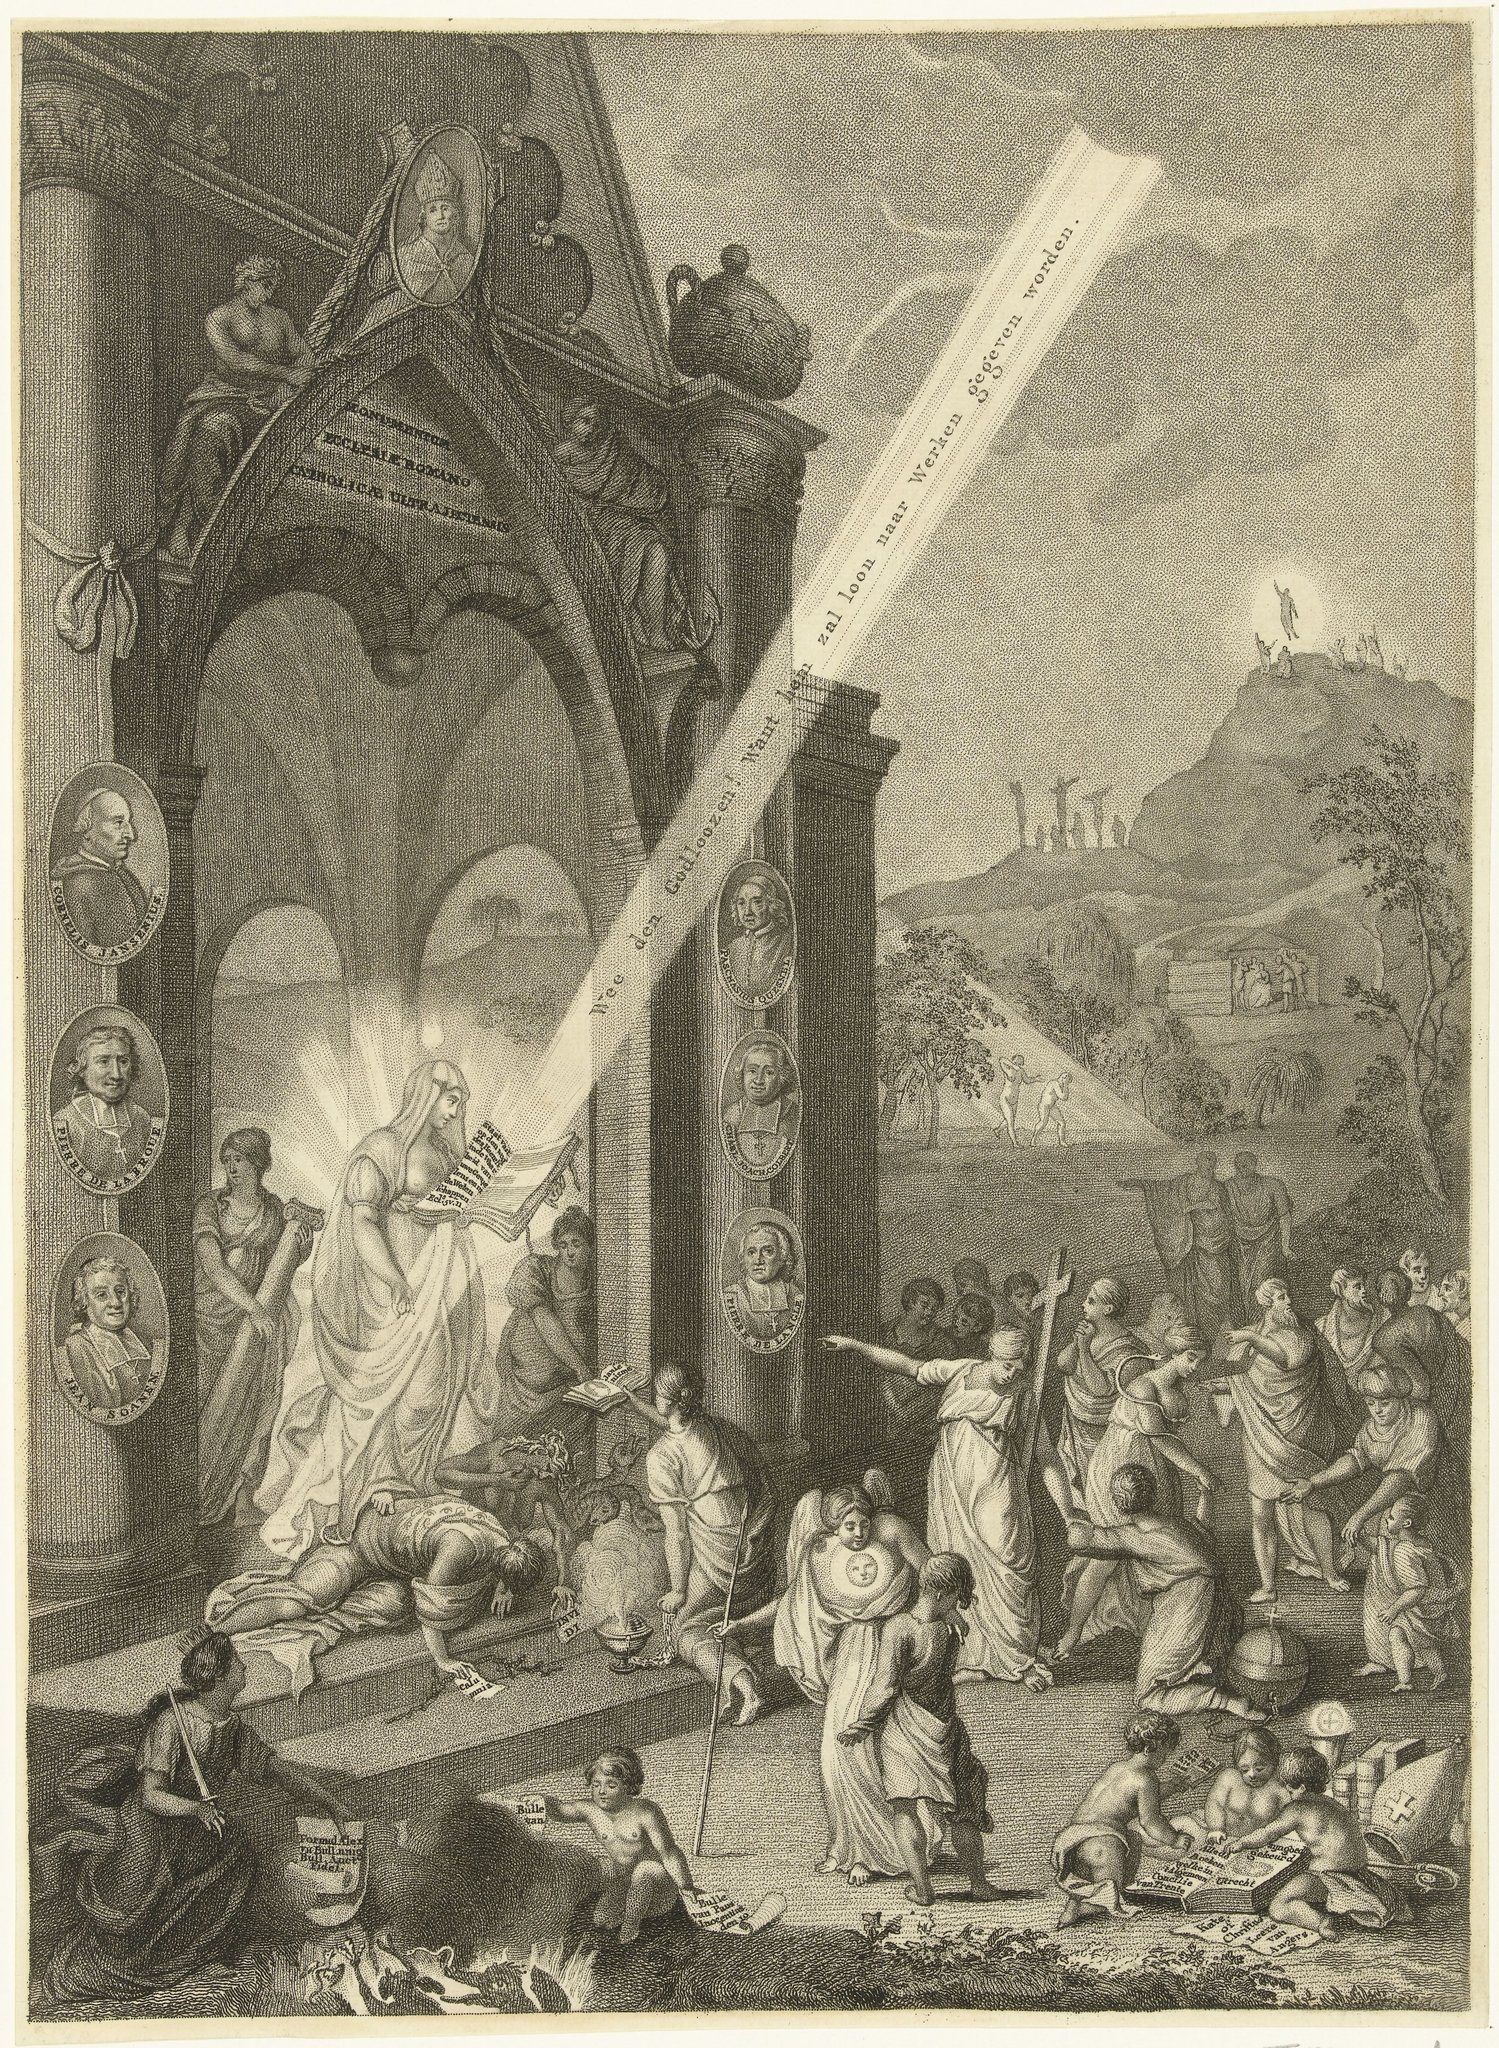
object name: print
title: Allegorie ter ere van de jansenisten, 1724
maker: Anonymous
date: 1724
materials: paper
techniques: etching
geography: northern netherlands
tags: representants of the church (christians in general, laymen, monks, etc.) in strife with each other or with opponents, allegorical representations ~ religion; 'religione', 'religione de ss. mauritio e lazaro', 'religione vera christiana' (ripa)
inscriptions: collector's mark: Lugt 2228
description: Allegorie ter ere van de jansenisten en Quesnel. Links het monument van de Rooms-Katholieke Kerk van Utrecht, versierd met zes portretten van jansenisten, in de opening staat de Godsdienst beschenen door een straal goddelijk licht. Op de voorgrond het verscheuren en verbranden van pauselijke bullen.